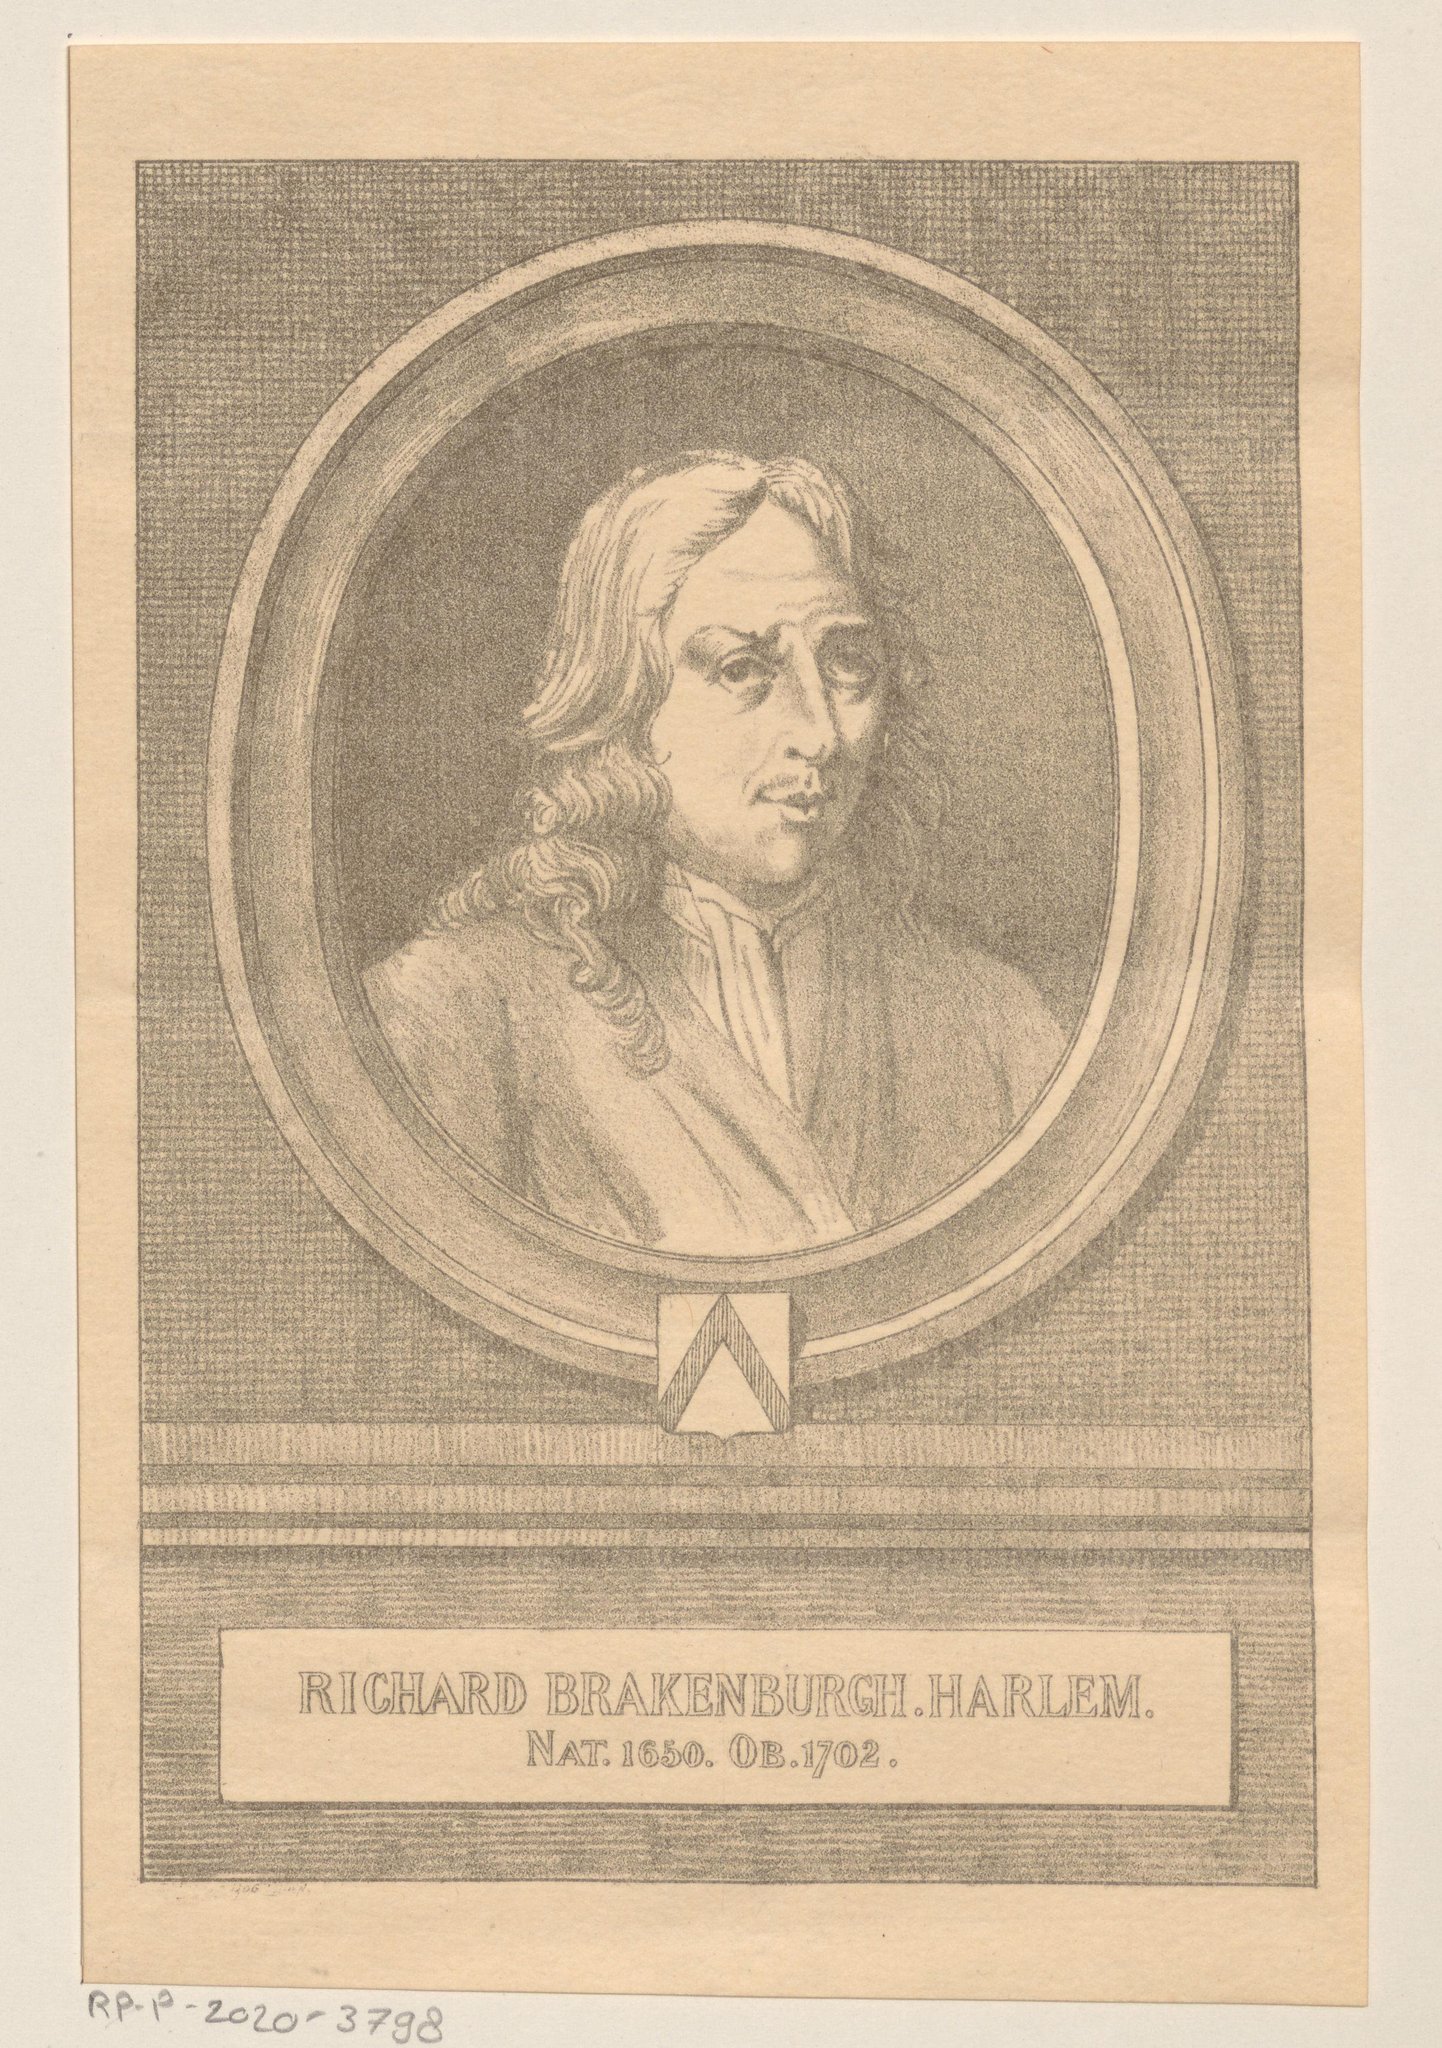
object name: print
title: Portret van Richard Brakenburg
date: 1825-1874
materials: paper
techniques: lithograph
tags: haarlem, print maker, richard brakenburg, historical persons, portrait, self-portrait of painter, armorial bearing, heraldry